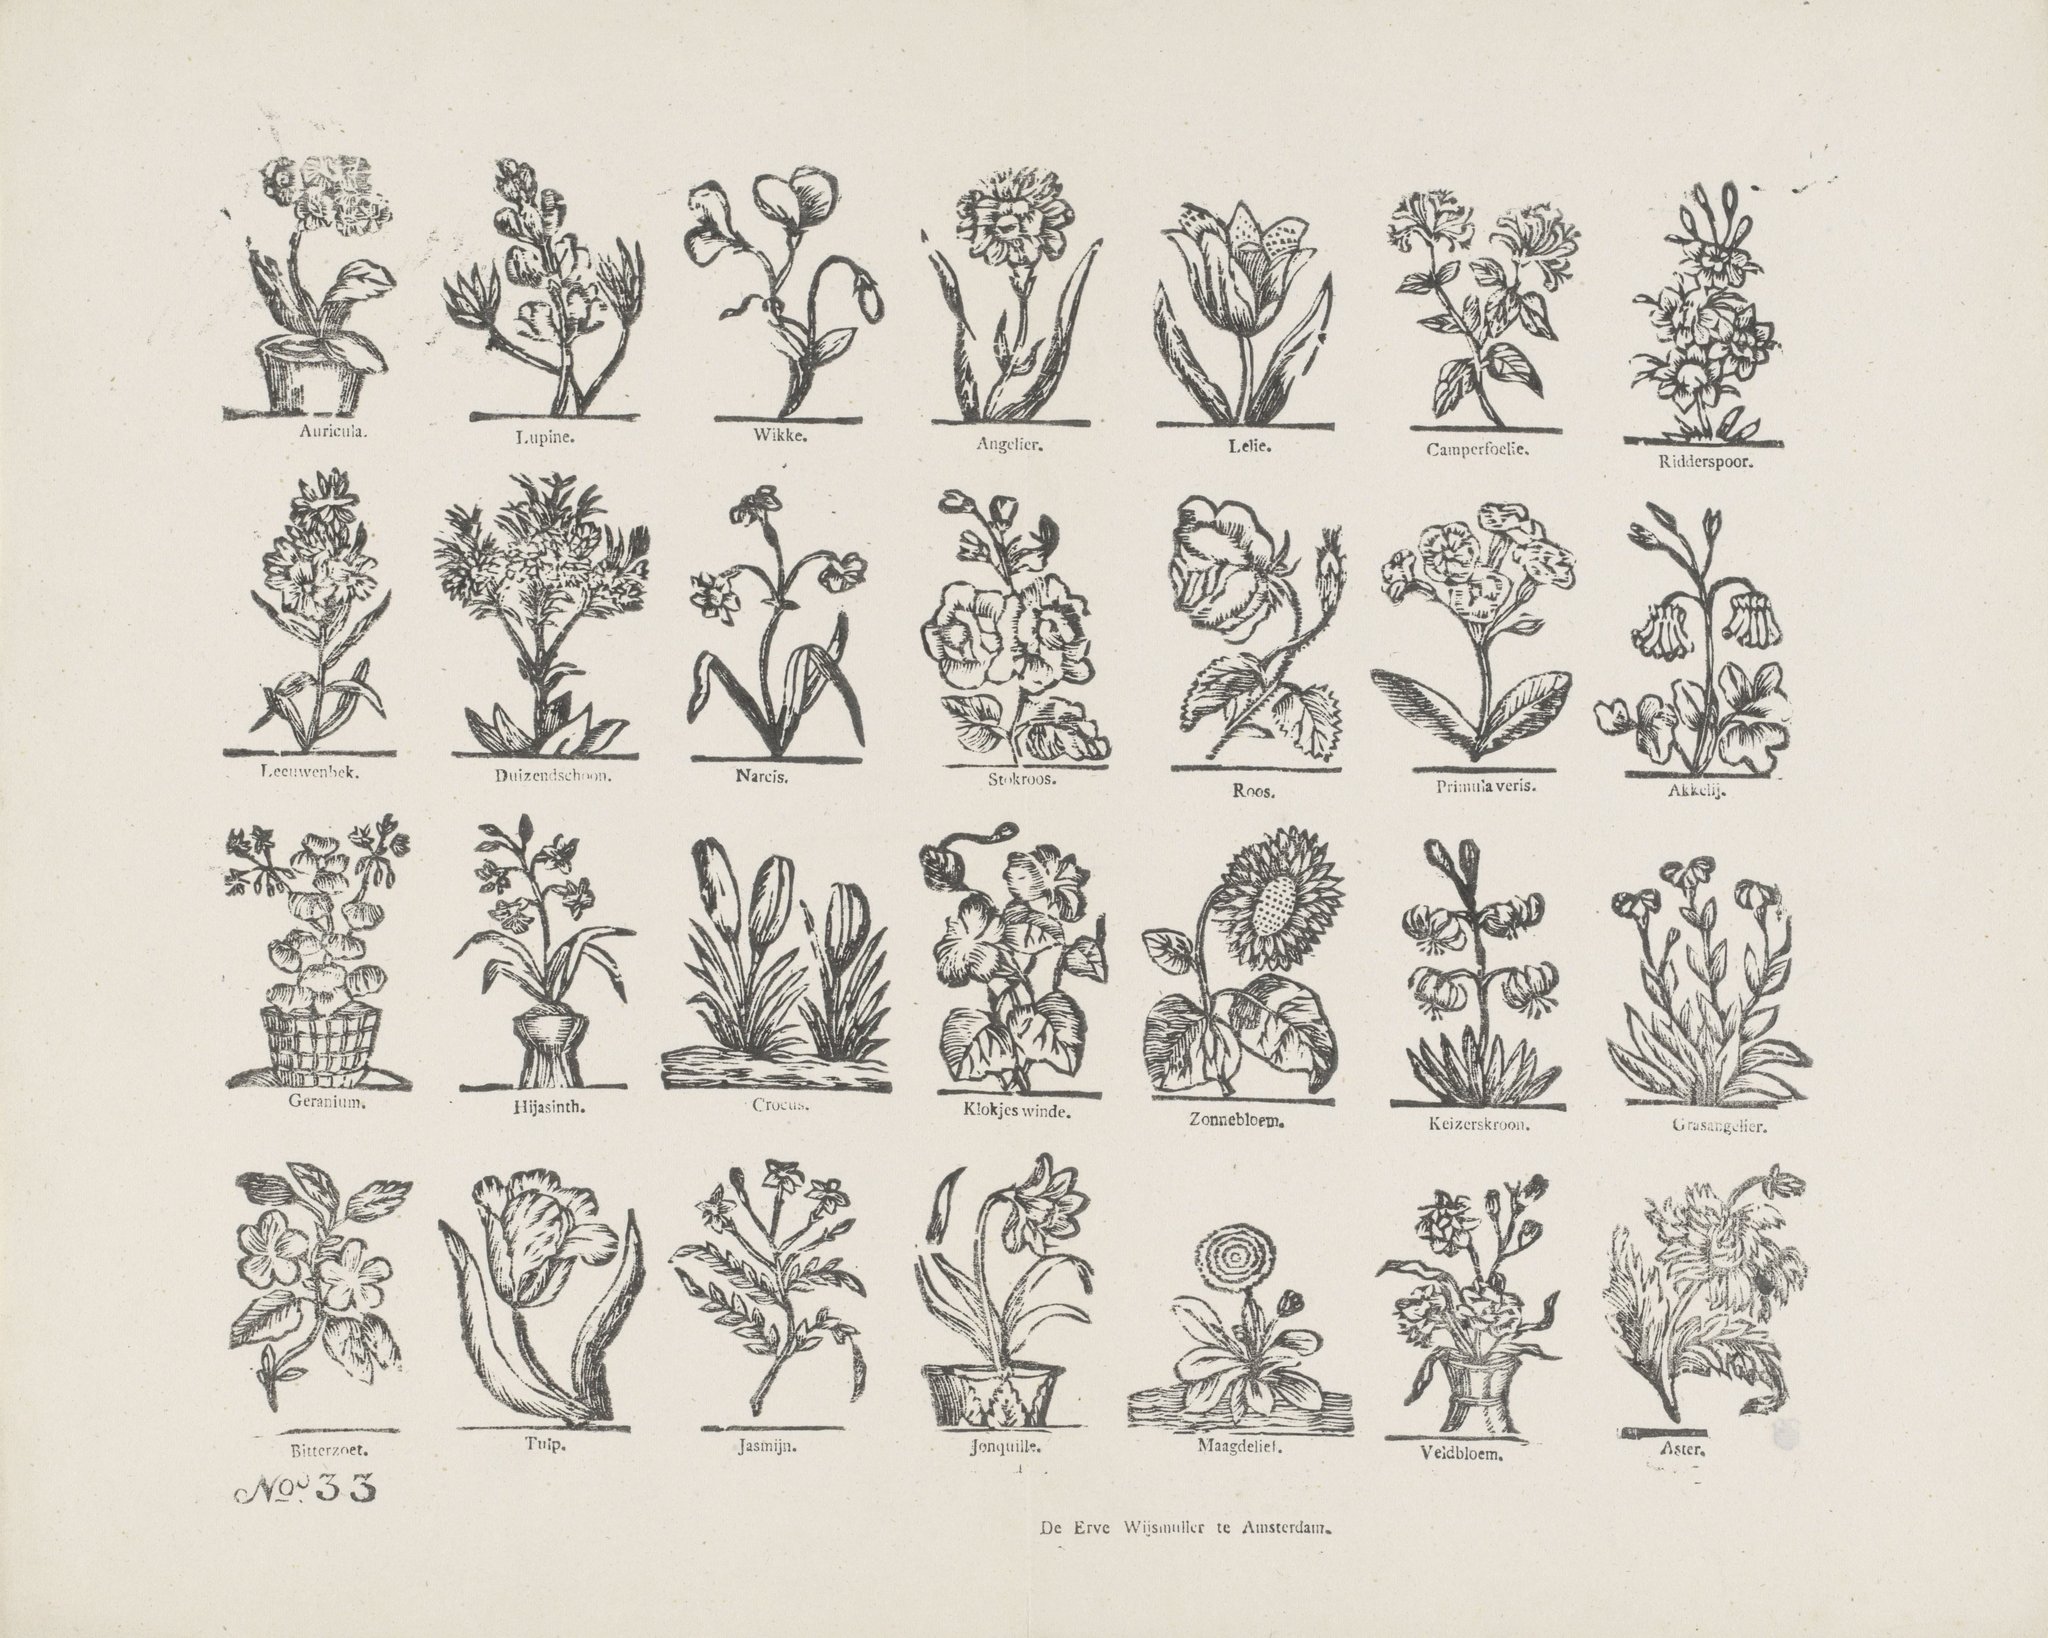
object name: popular print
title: Bloemen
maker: Anonymous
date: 1828-1913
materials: paper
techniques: letterpress printing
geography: netherlands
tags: flowers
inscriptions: collector's mark: Lugt 2760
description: Blad met 28 voorstellingen van bloemen, zoals een lelie, een narcis en een zonnebloem. Onder elke afbeelding een onderschrift in boekdruk. Genummerd linksonder: No. 33.